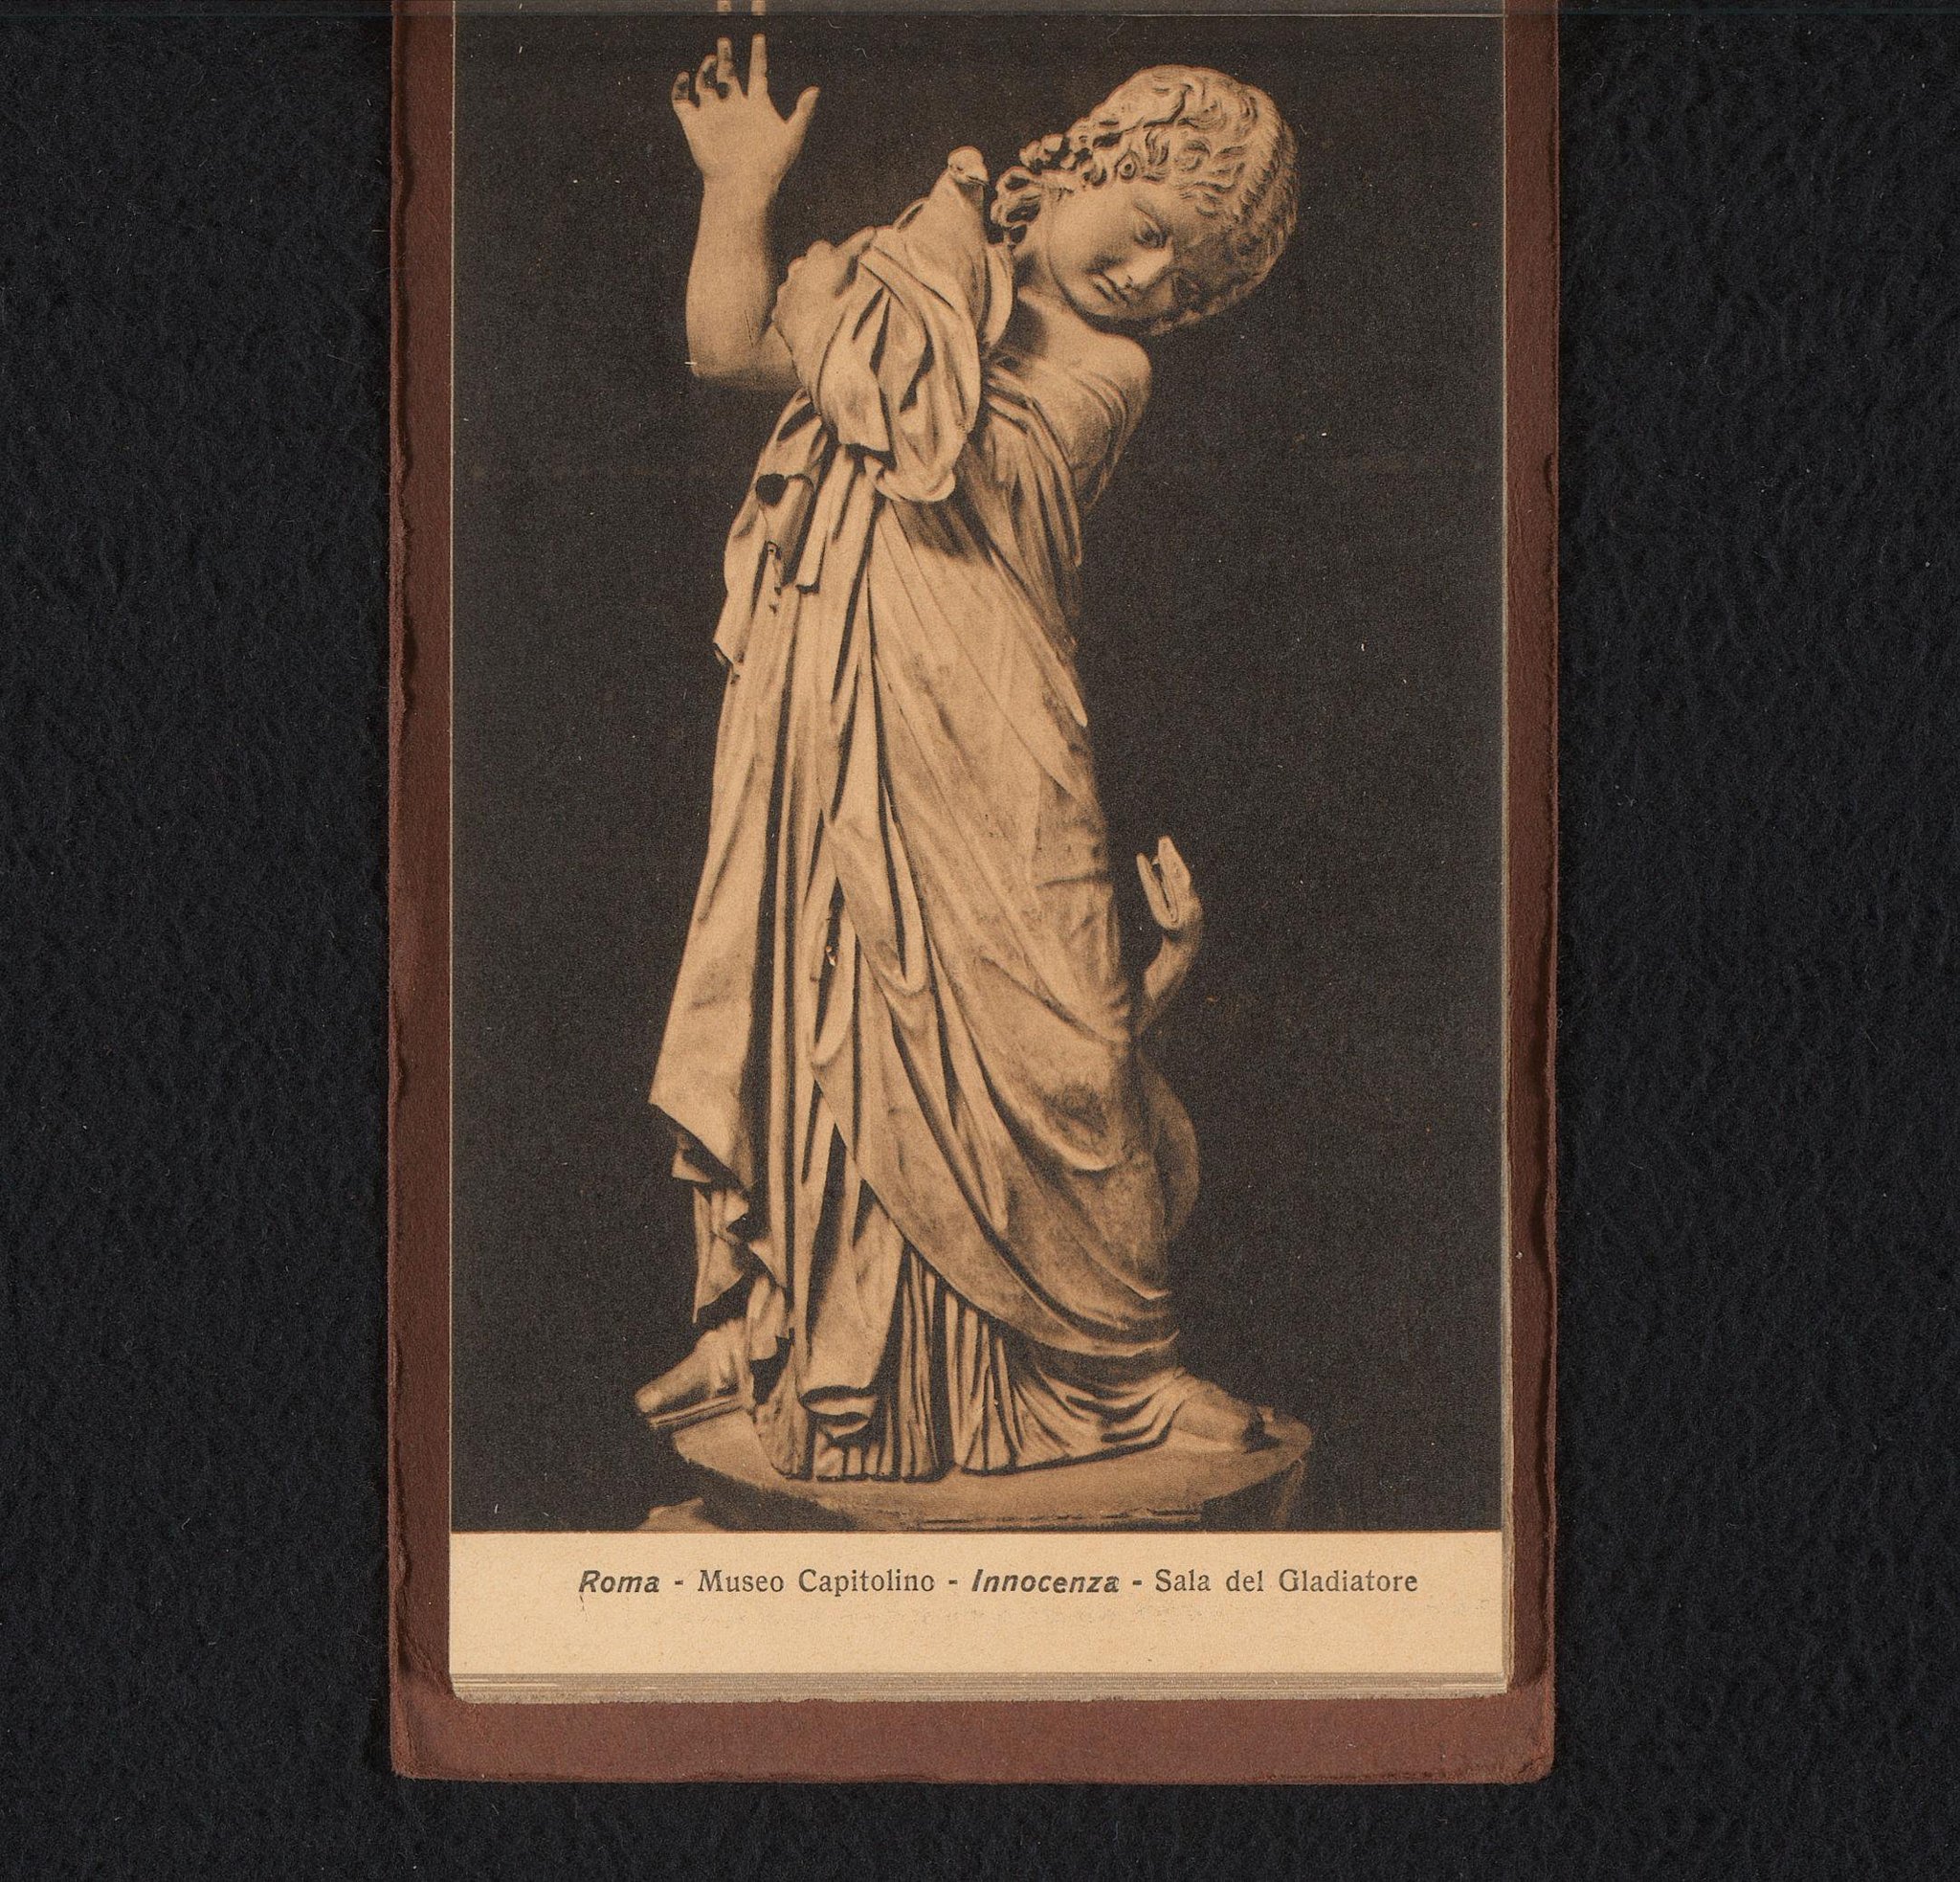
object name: ansichtkaart, prentbriefkaart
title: Roma - Museo Capitolino - Innocenza - Sala del Gladiatore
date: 1905-1930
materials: cardboard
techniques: photograph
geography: rome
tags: statues, paintings, etc. ~ objects of worship in roman religion, permanent exhibition, museum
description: Prentbriefkaart maakt deel uit van een album.